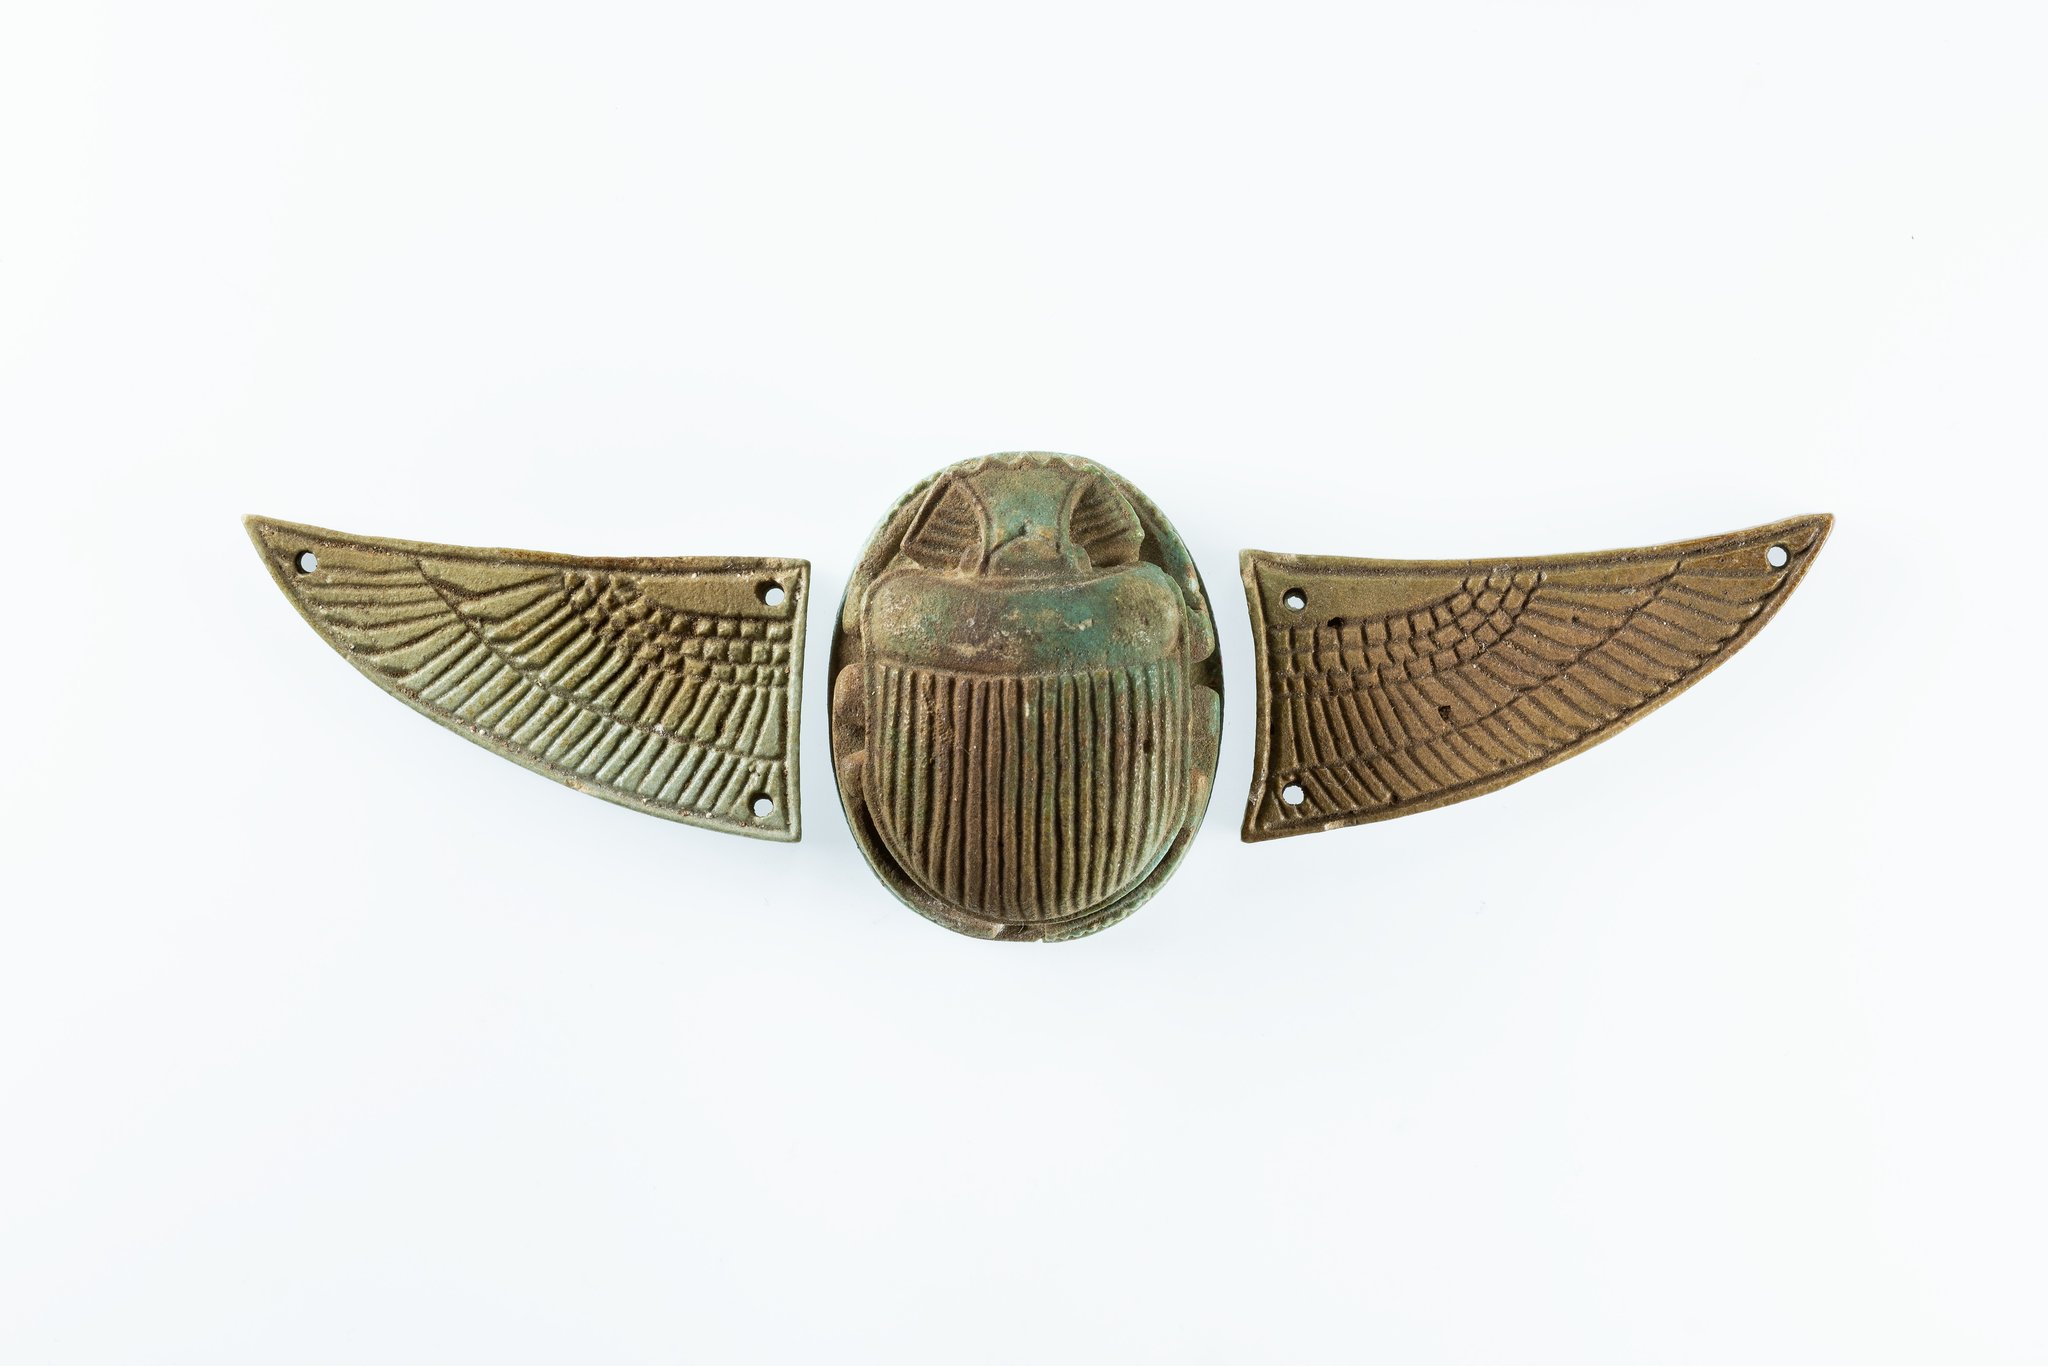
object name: amulet, winged scarab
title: Winged Scarab Amulet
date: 664-332 BCE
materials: faience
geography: egypt